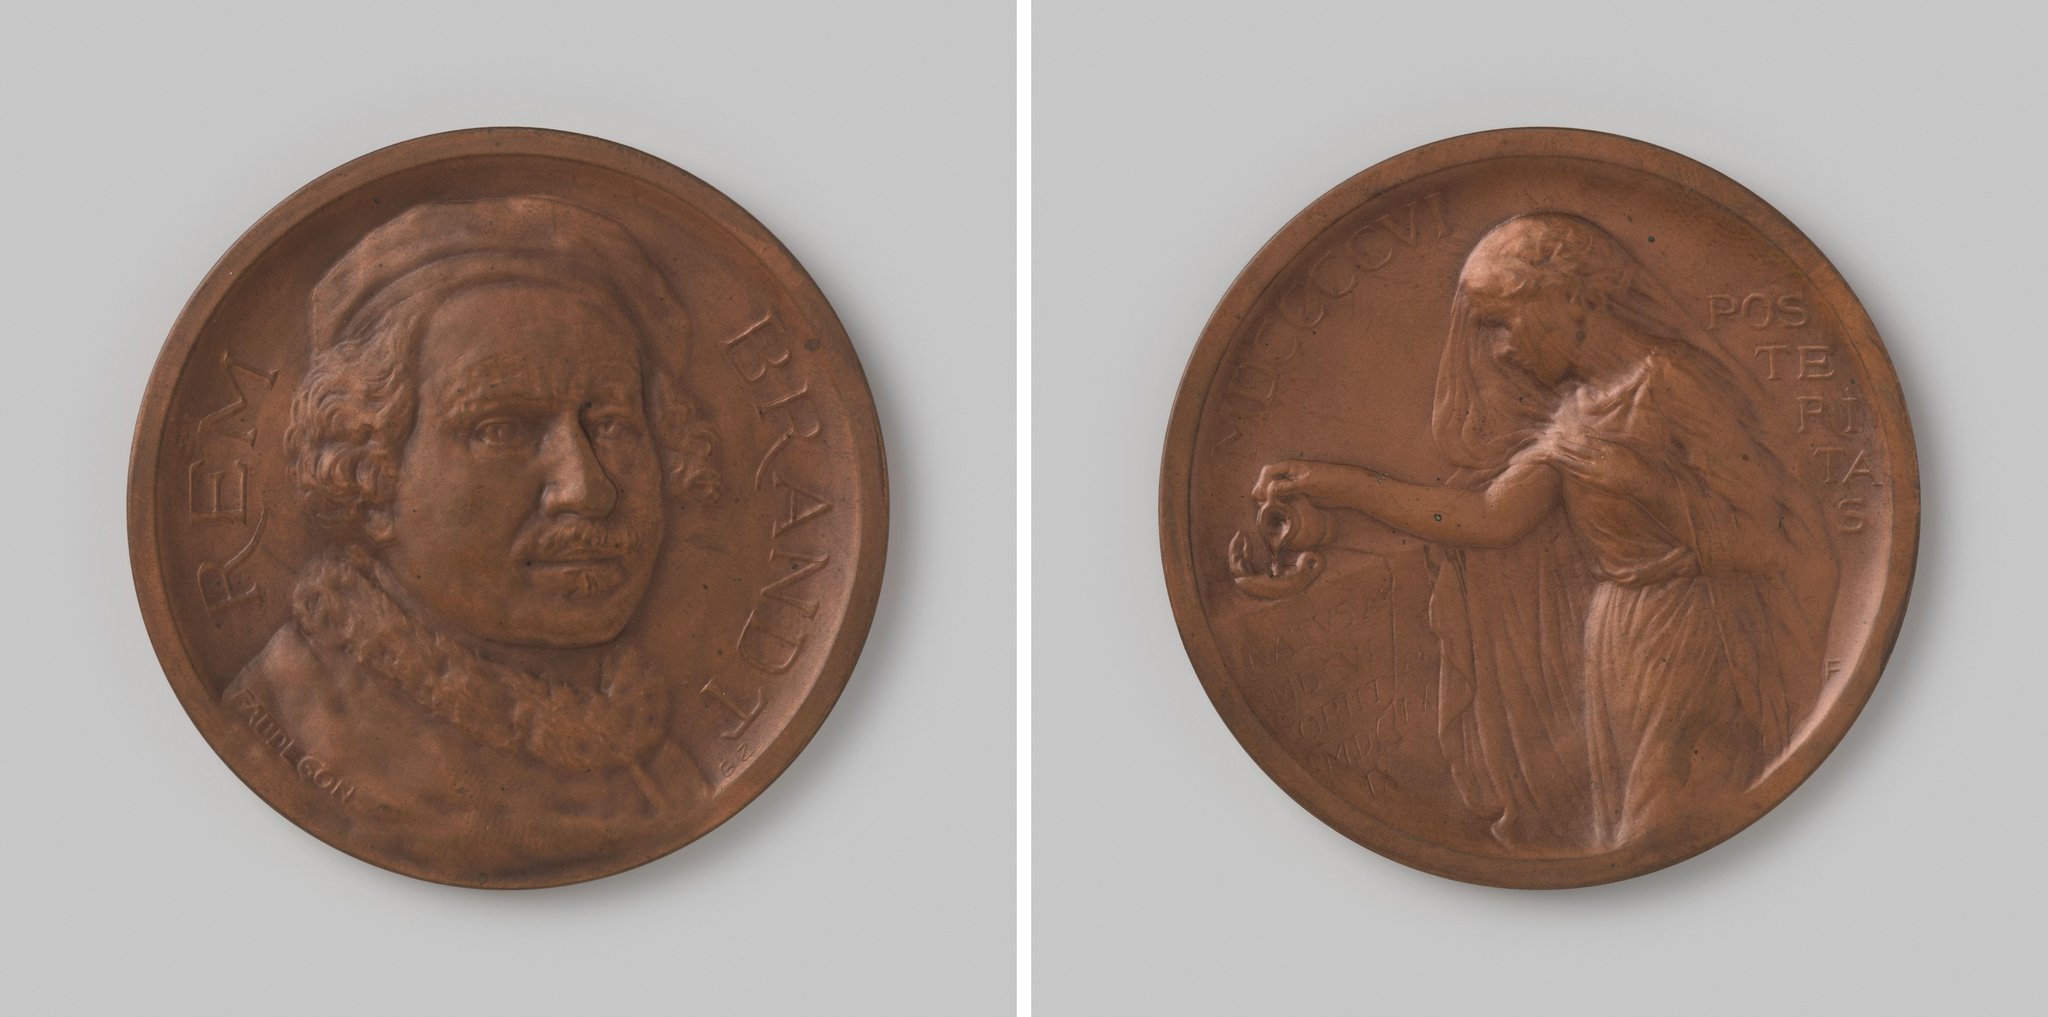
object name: history medal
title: Driehonderdste geboortedag van Rembrandt van Rijn 1906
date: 1905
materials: bronze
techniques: striking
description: Bronzen penning, op de voorzijde het borstbeeld van Rembrandt half van rechts met omschrift, op de keerzijde een gesluierde vrouw naar links die een olielamp vult, met omschrift bovenaan en beiderzijds tekst in het veld.